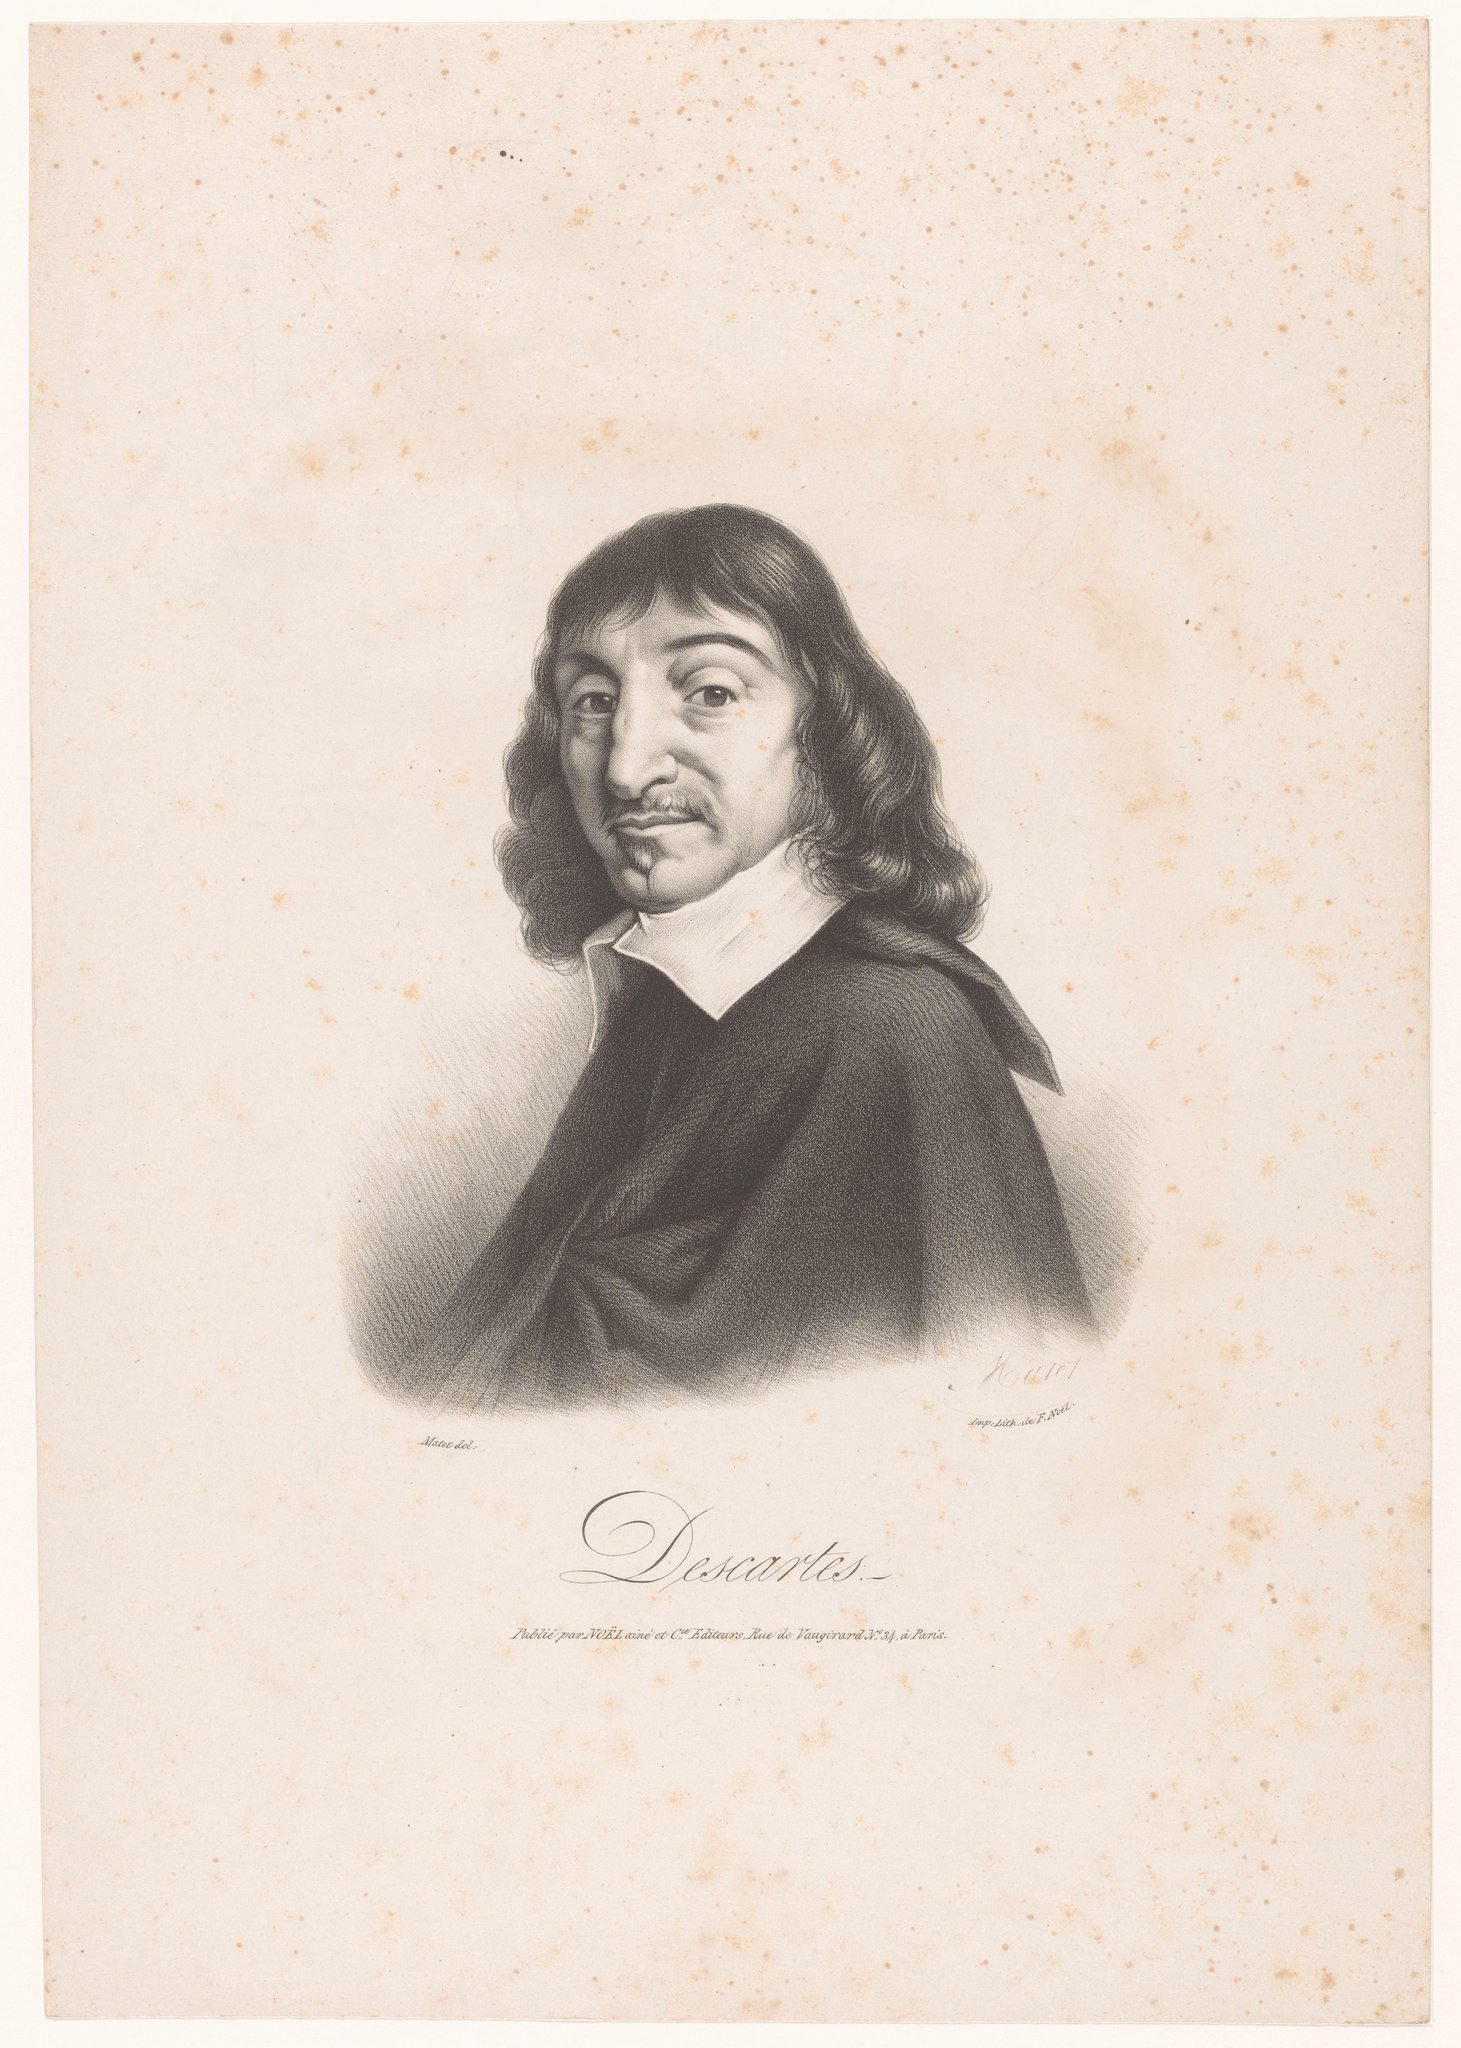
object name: print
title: Portret van René Descartes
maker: charles paulin françois matet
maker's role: print maker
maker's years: 1791-1870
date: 1826-1827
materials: paper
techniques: lithograph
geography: paris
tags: rené descartes, historical persons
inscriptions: collector's mark: Lugt 2228